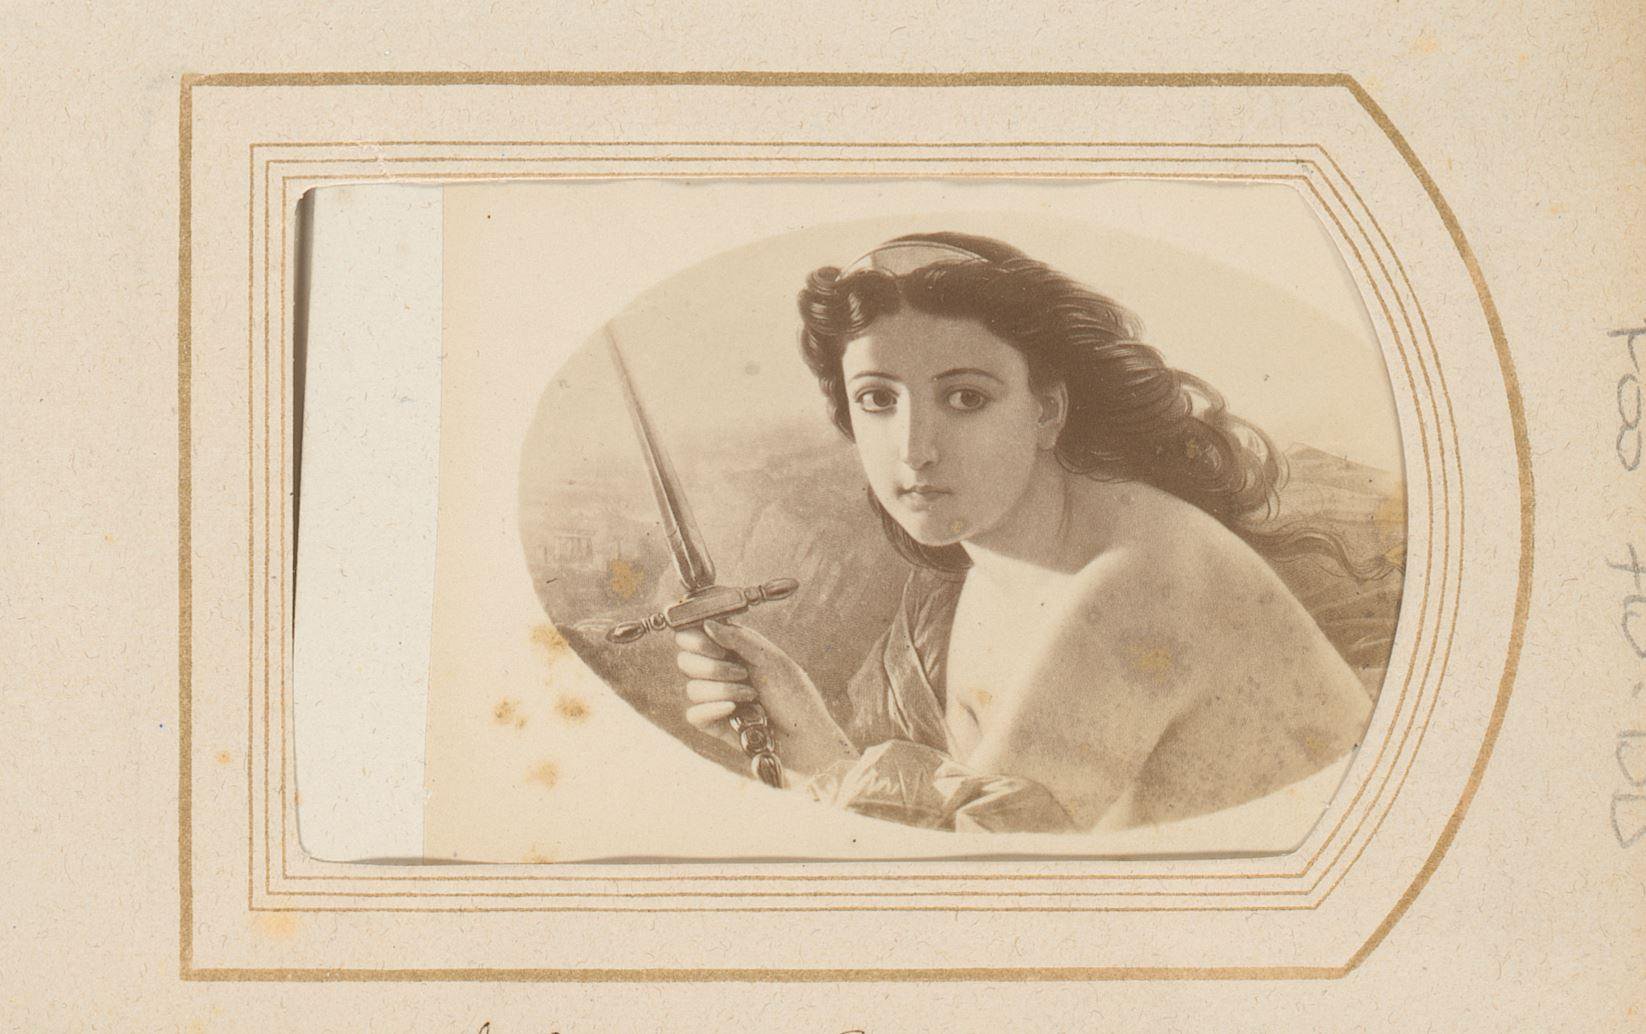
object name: reproduction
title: Fotoreproductie van L'age de fer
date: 1870-1890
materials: cardboard, photographic support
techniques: albumen print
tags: adult woman, hacking and thrusting weapons: sword, painting, drawing and the graphic arts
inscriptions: inscription: ‘Brochart./ 2987./ L'âge de fer./ Das eiserne Beitalter/ The iron age’, annotation: ‘das [...]’